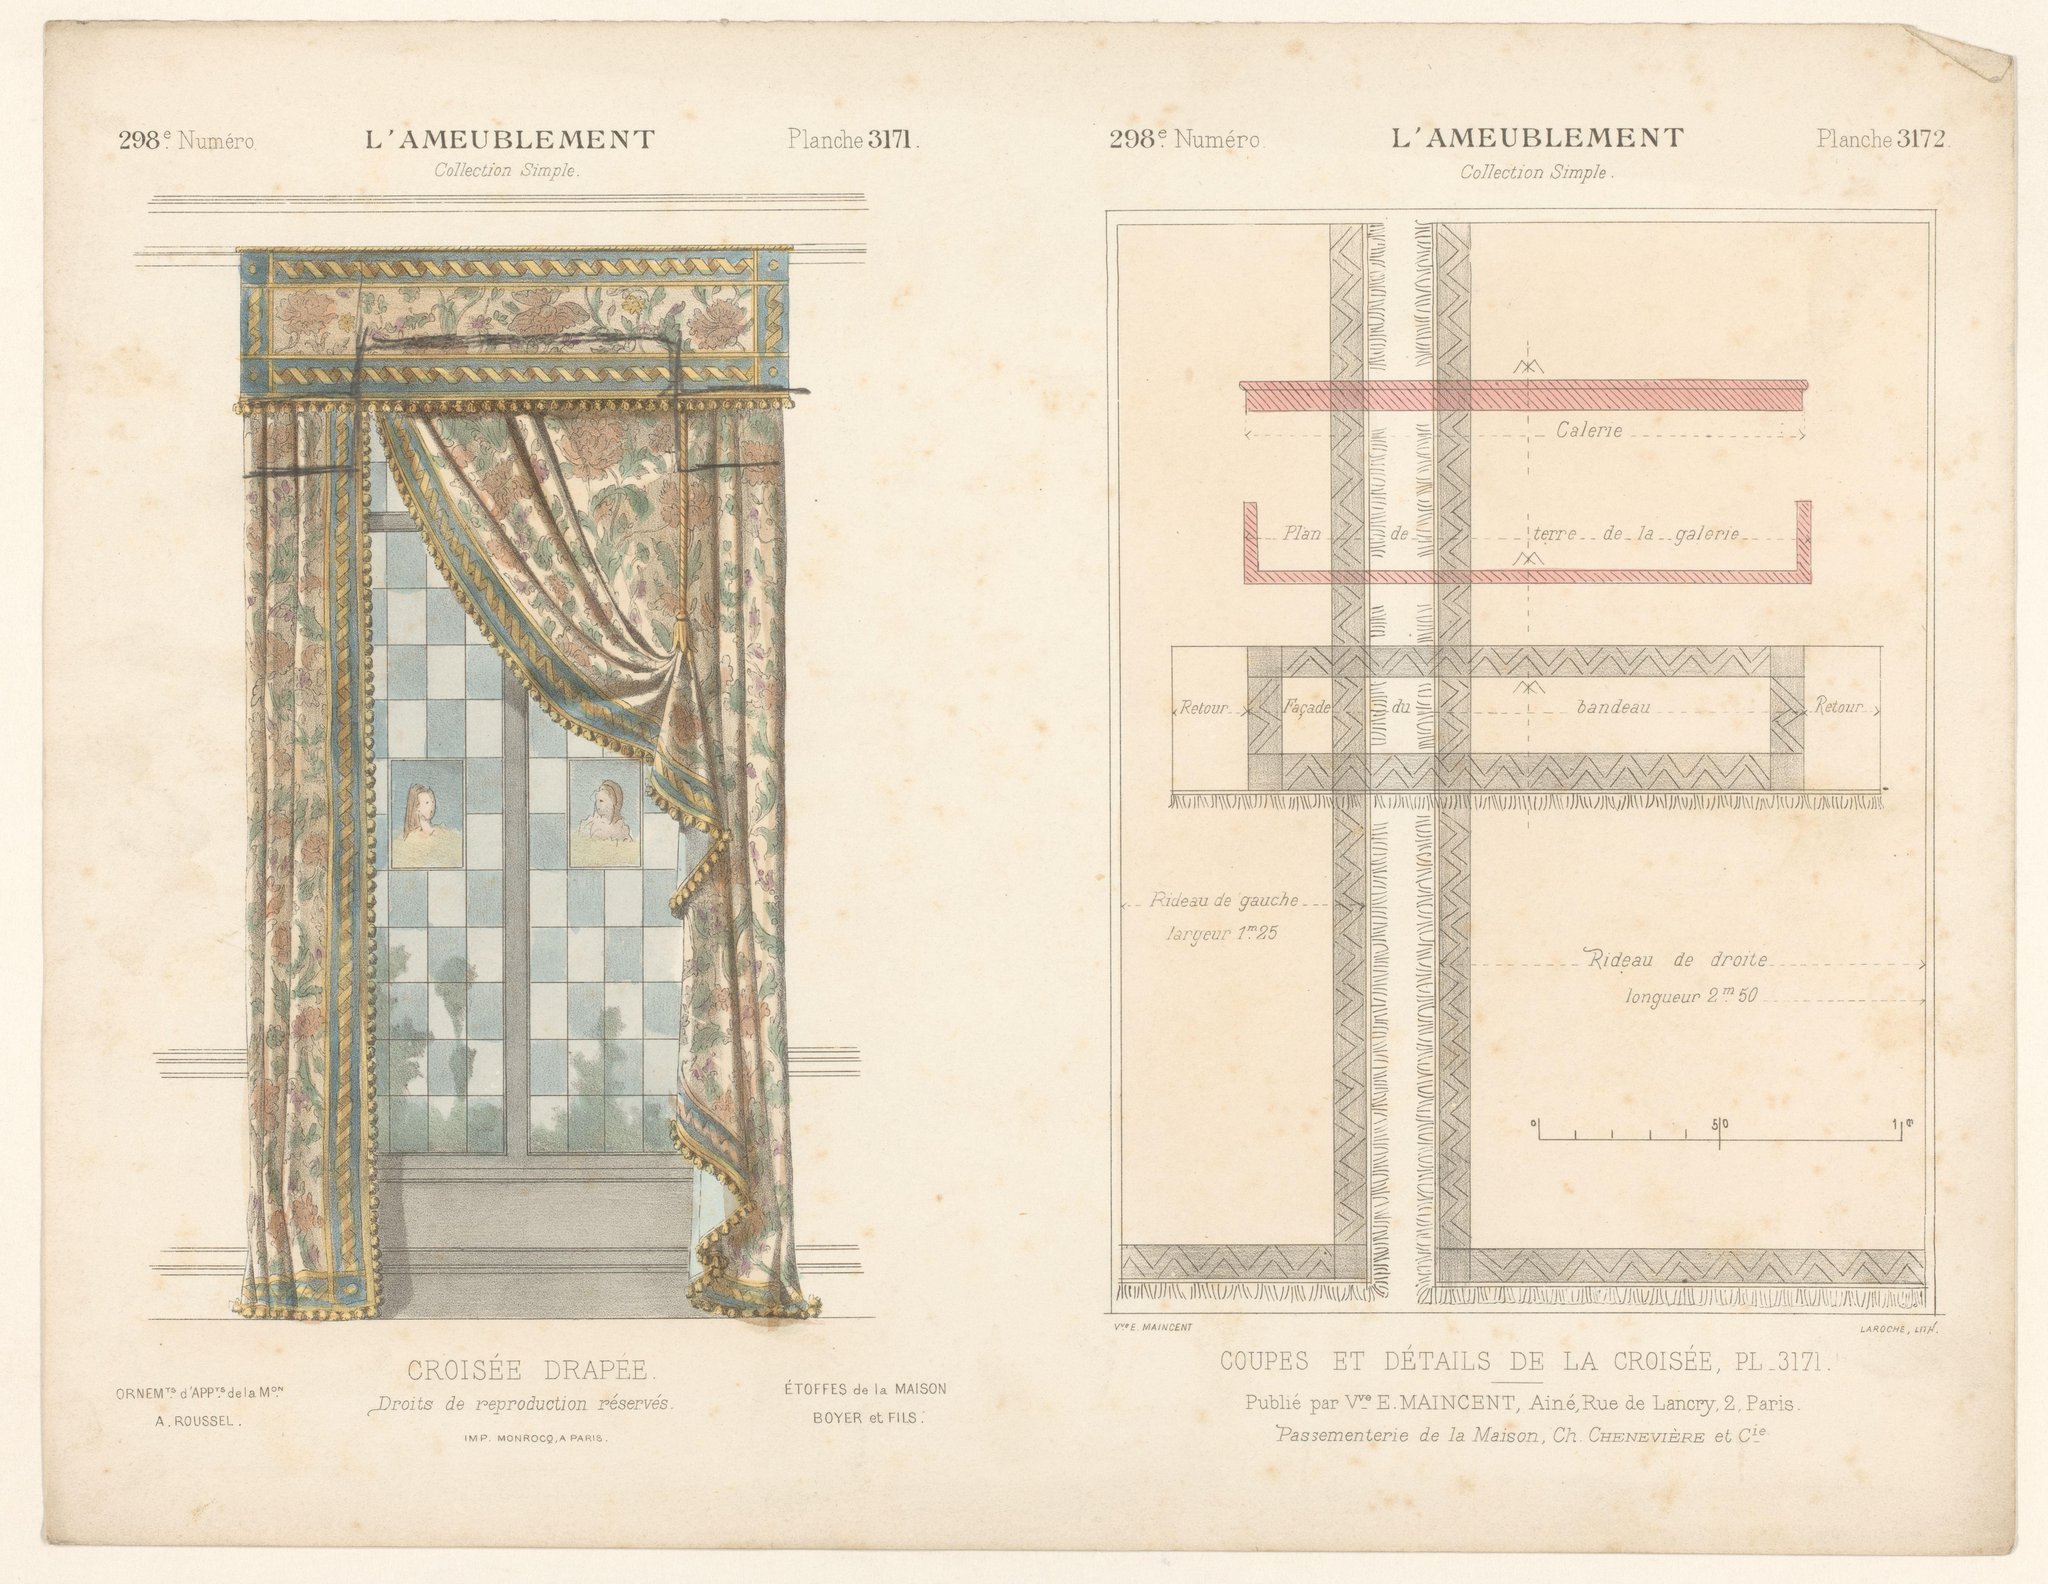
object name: print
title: L'ameublement / Collection simple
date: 1895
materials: paper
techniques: hand coloring, lithograph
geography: paris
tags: window, hangings and drapery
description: Een venster met gedrapeerde gordijnen. Rechts details van de draperieën. Prent uit 298e Livraison.